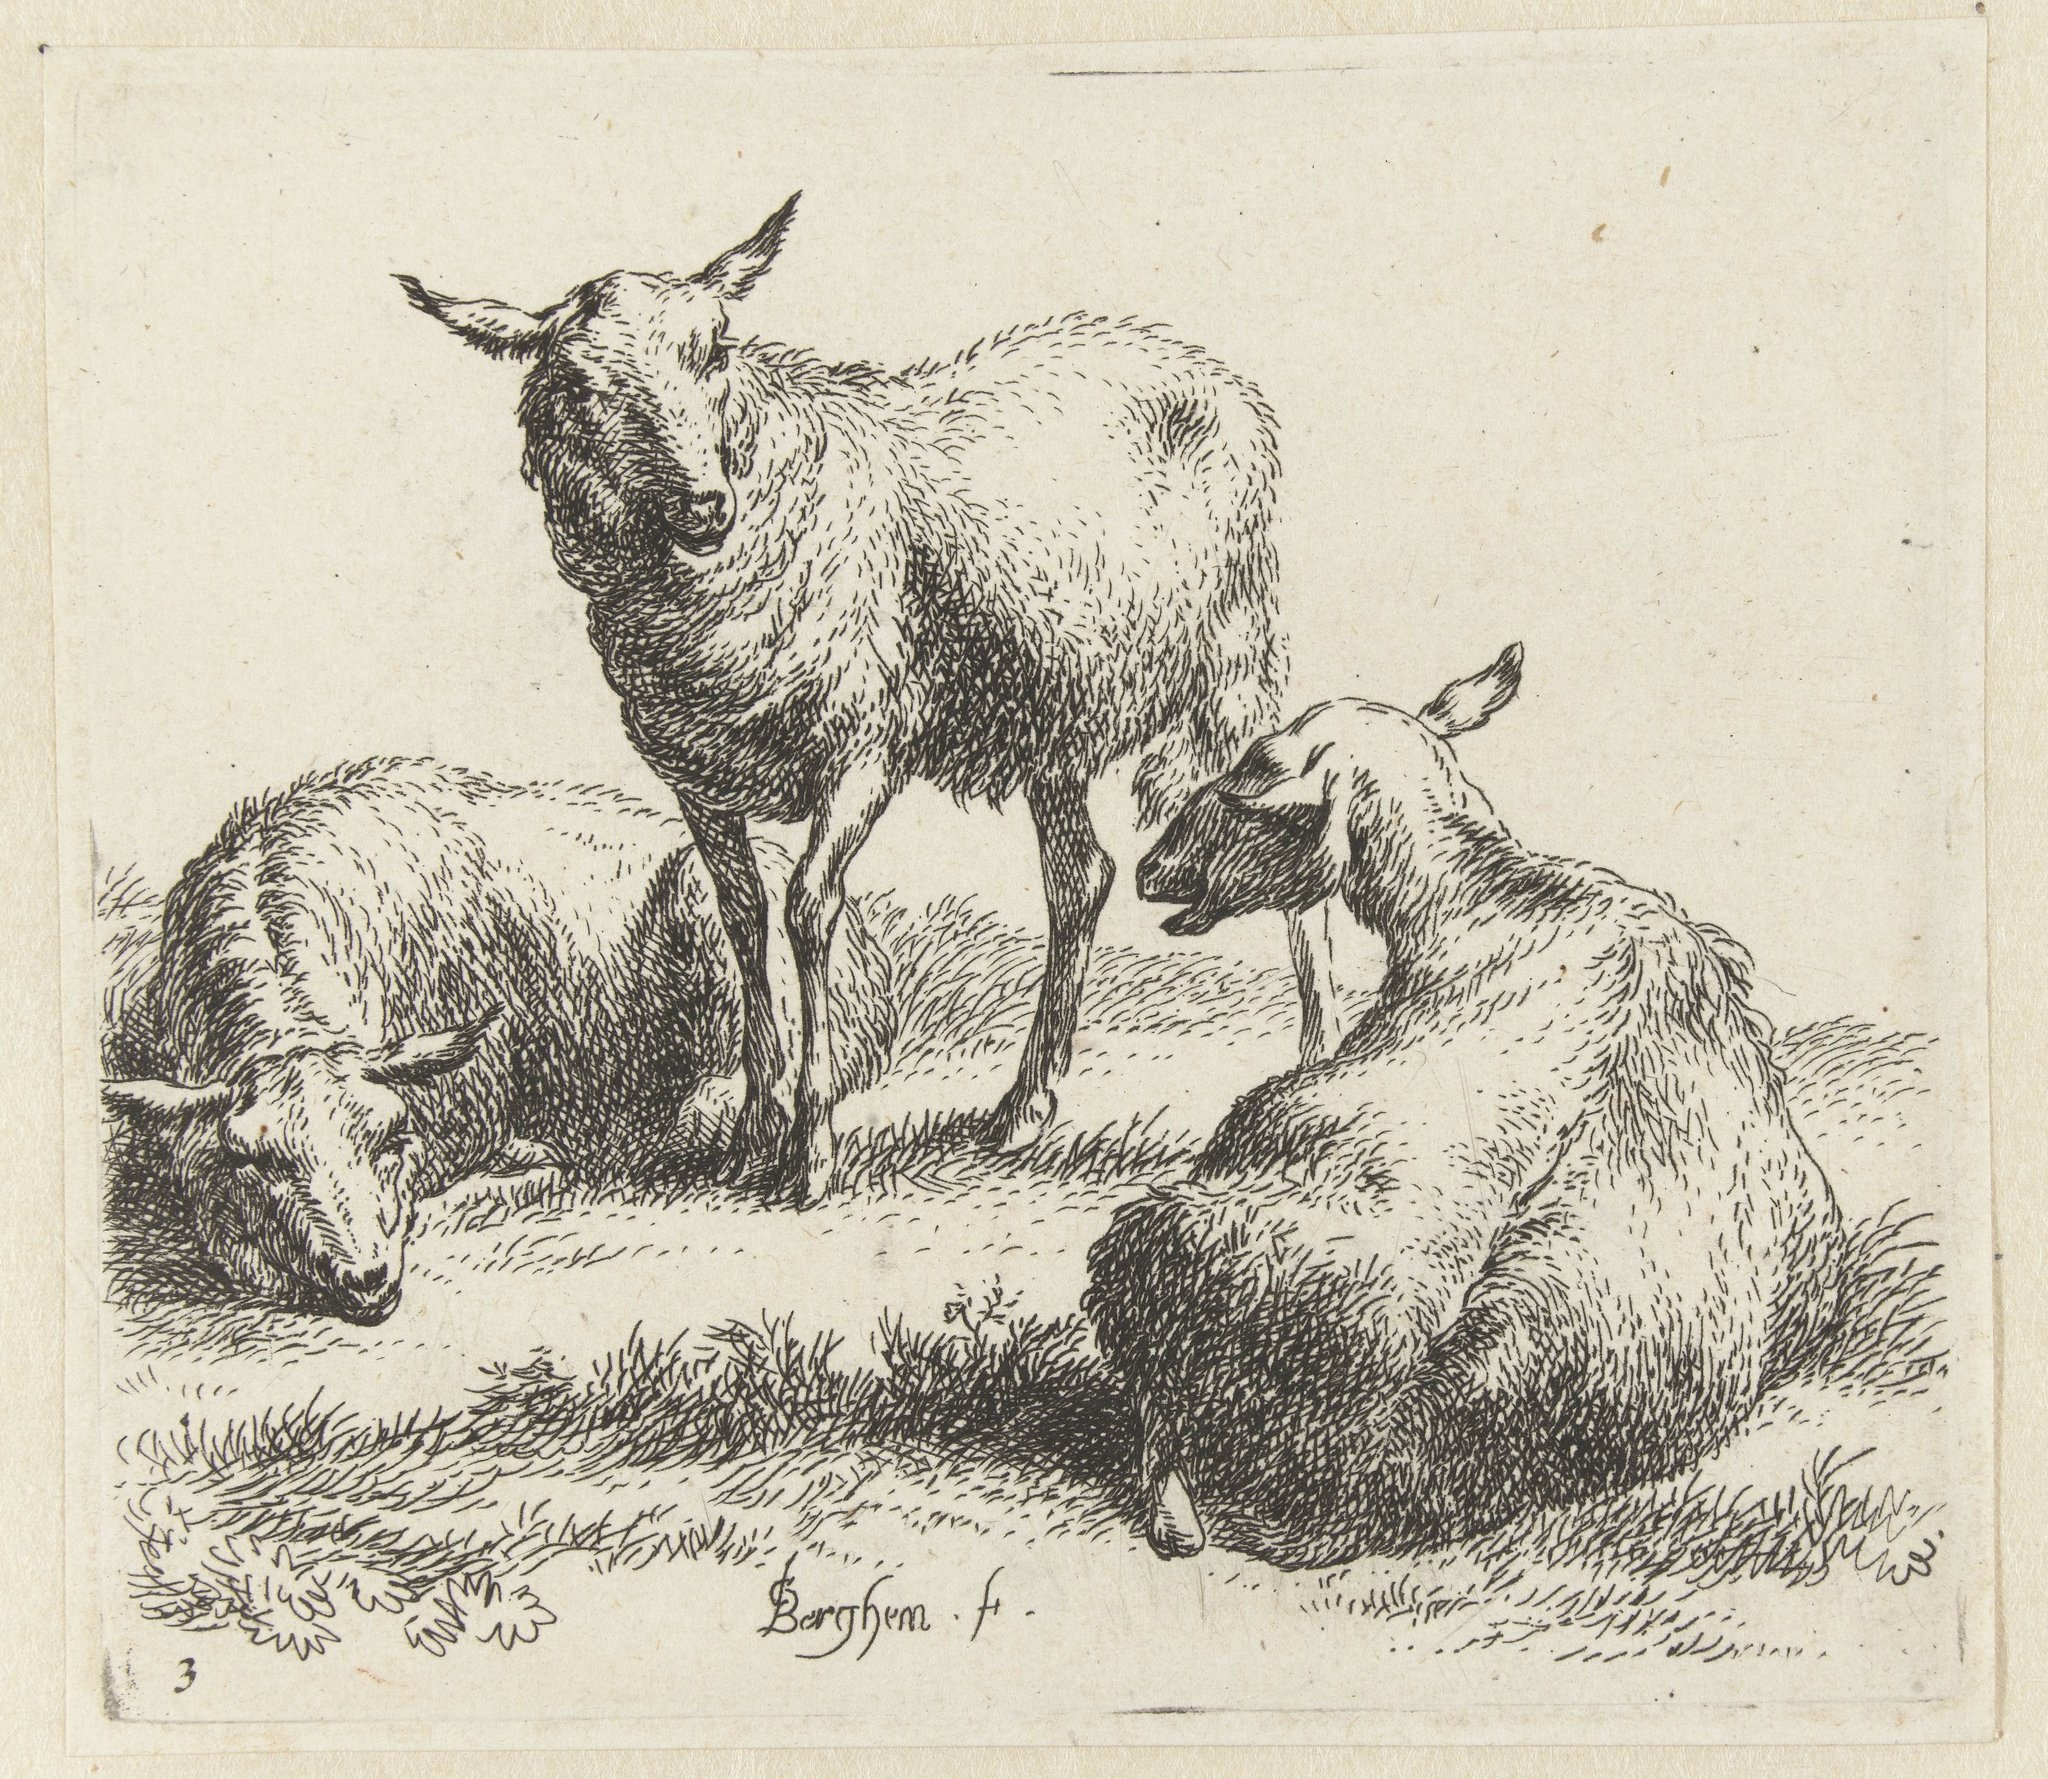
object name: print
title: Schapen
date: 1646-1652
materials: paper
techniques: etching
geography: netherlands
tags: sheep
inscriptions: collector's mark: Lugt 240